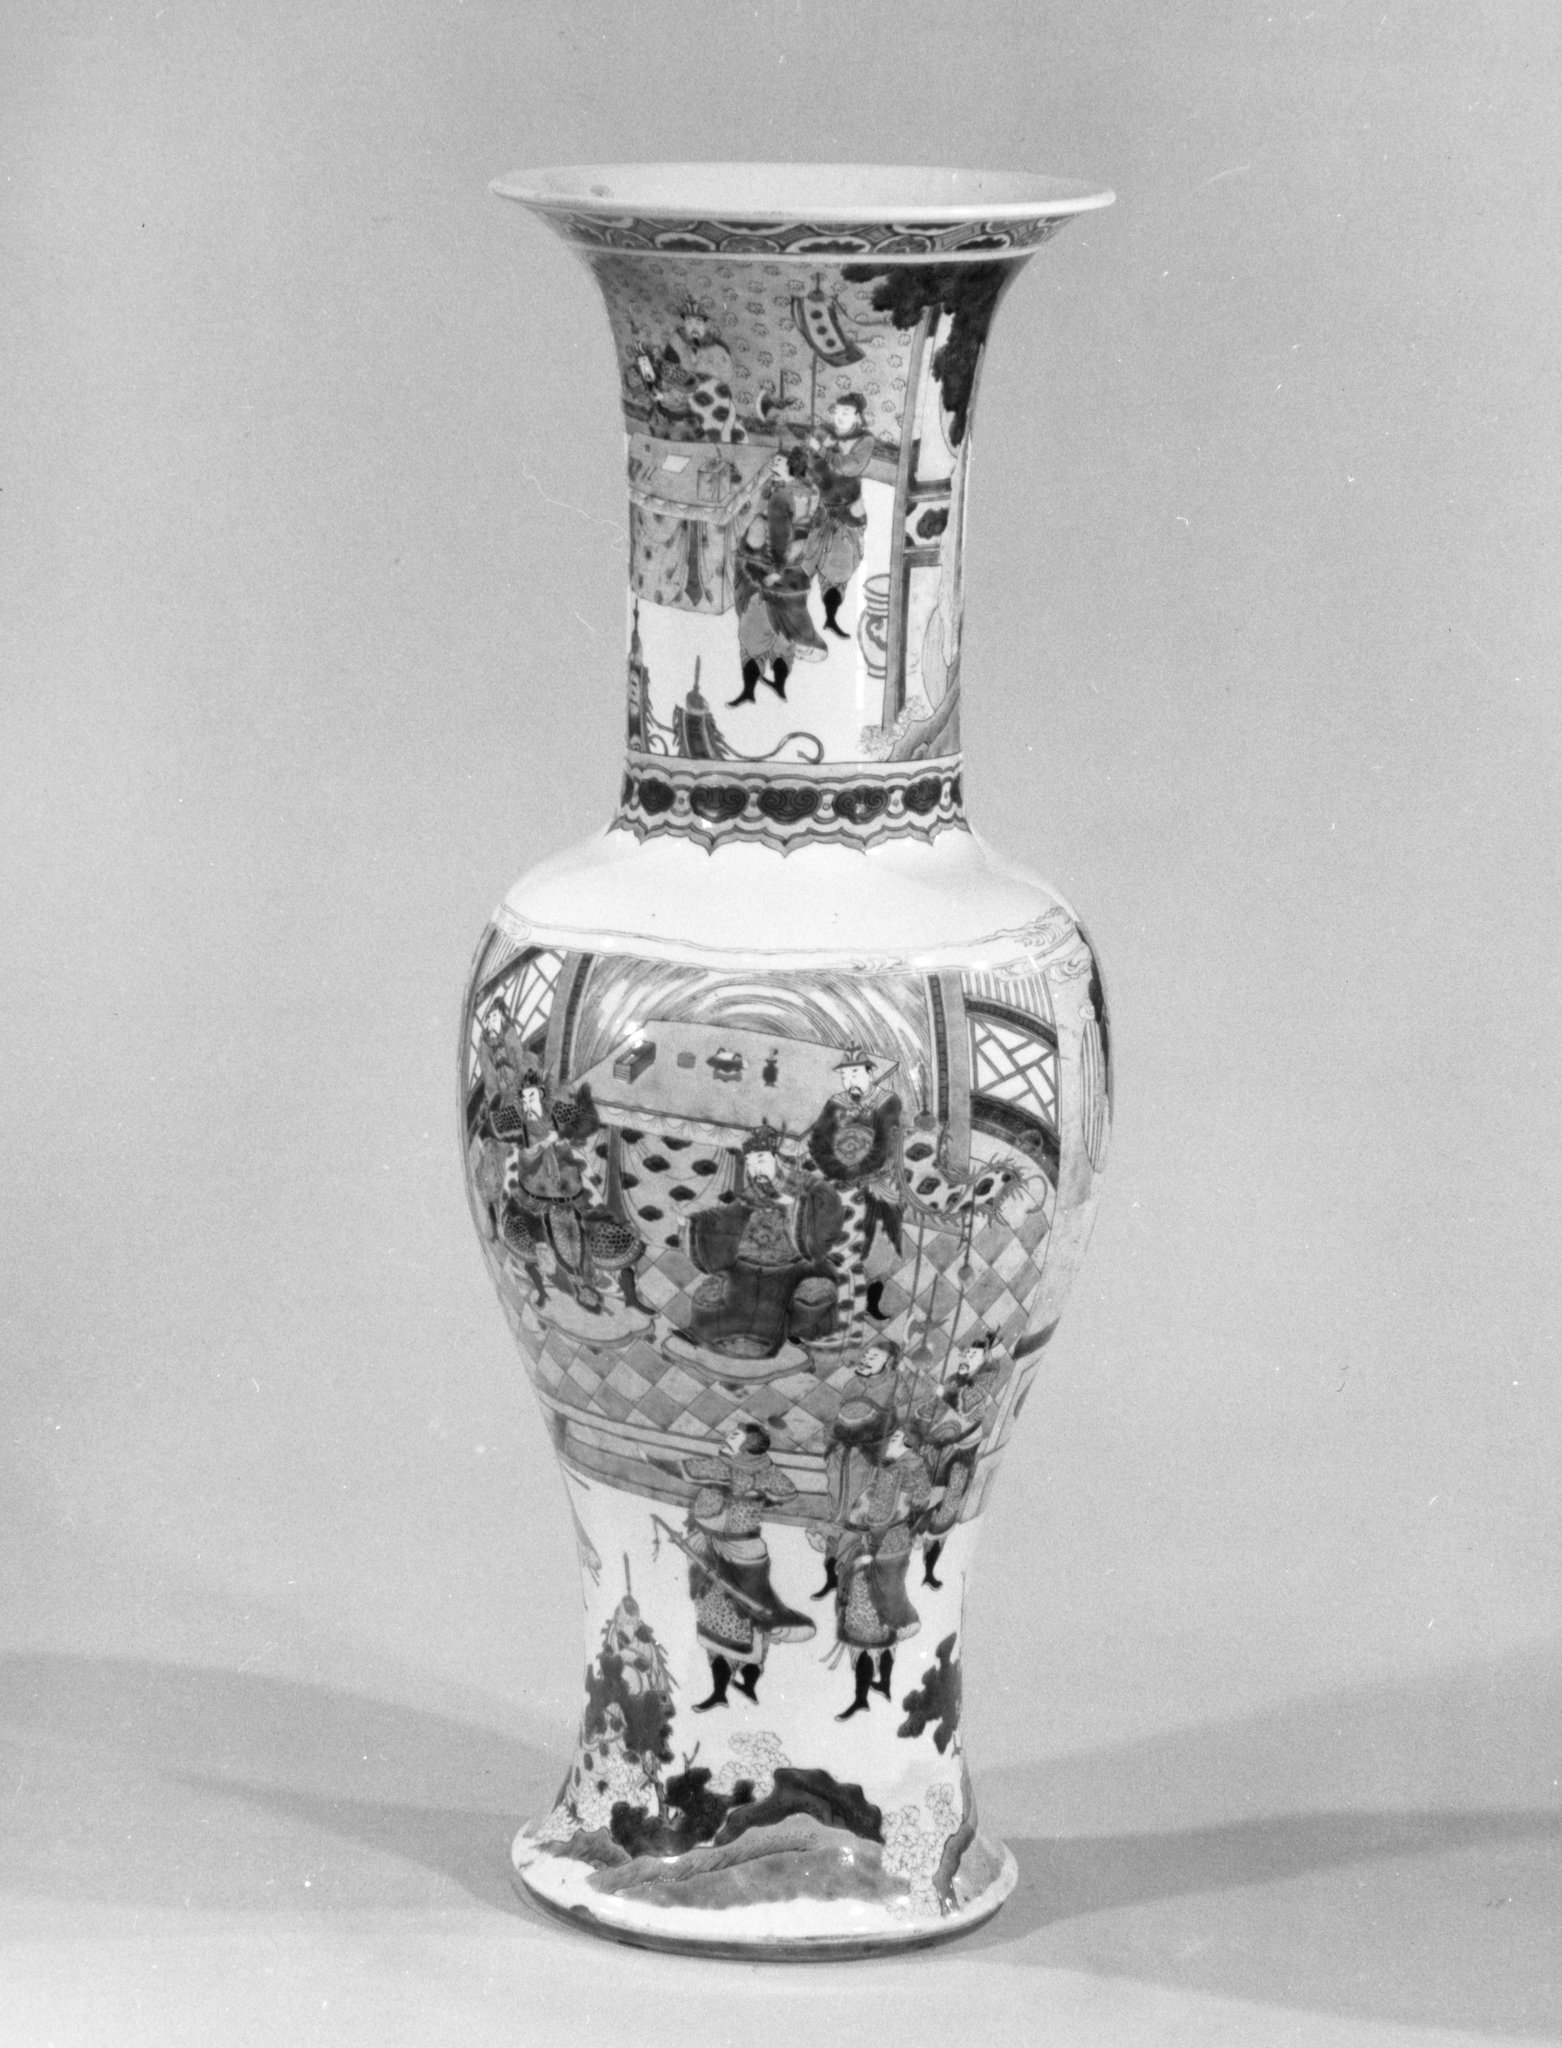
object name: vase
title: Vase with figural scenes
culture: chinese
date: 1667-1733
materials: enamel, porcelain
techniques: overglaze, painting, polychrome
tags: men,tables